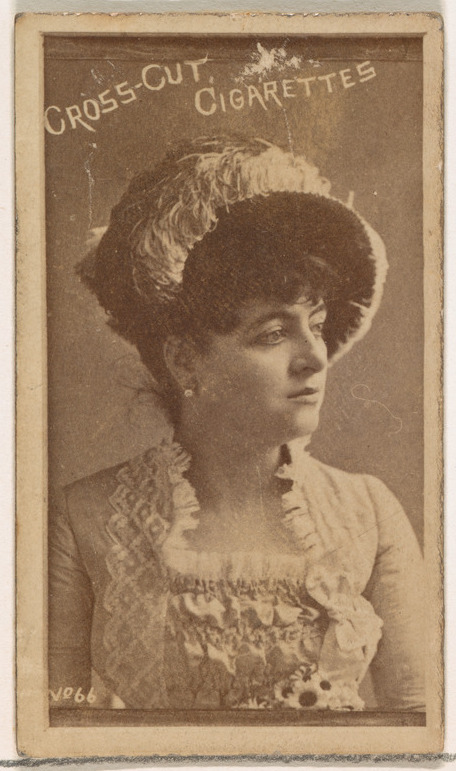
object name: print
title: Card Number 66, from the Actors and Actresses series (N145-1) issued by Duke Sons & Co. to promote Cross Cut Cigarettes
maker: w. duke, sons & co.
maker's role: publisher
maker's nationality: american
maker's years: 1870-1920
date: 1880-1889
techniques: albumen silver print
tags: portraits,women,actresses